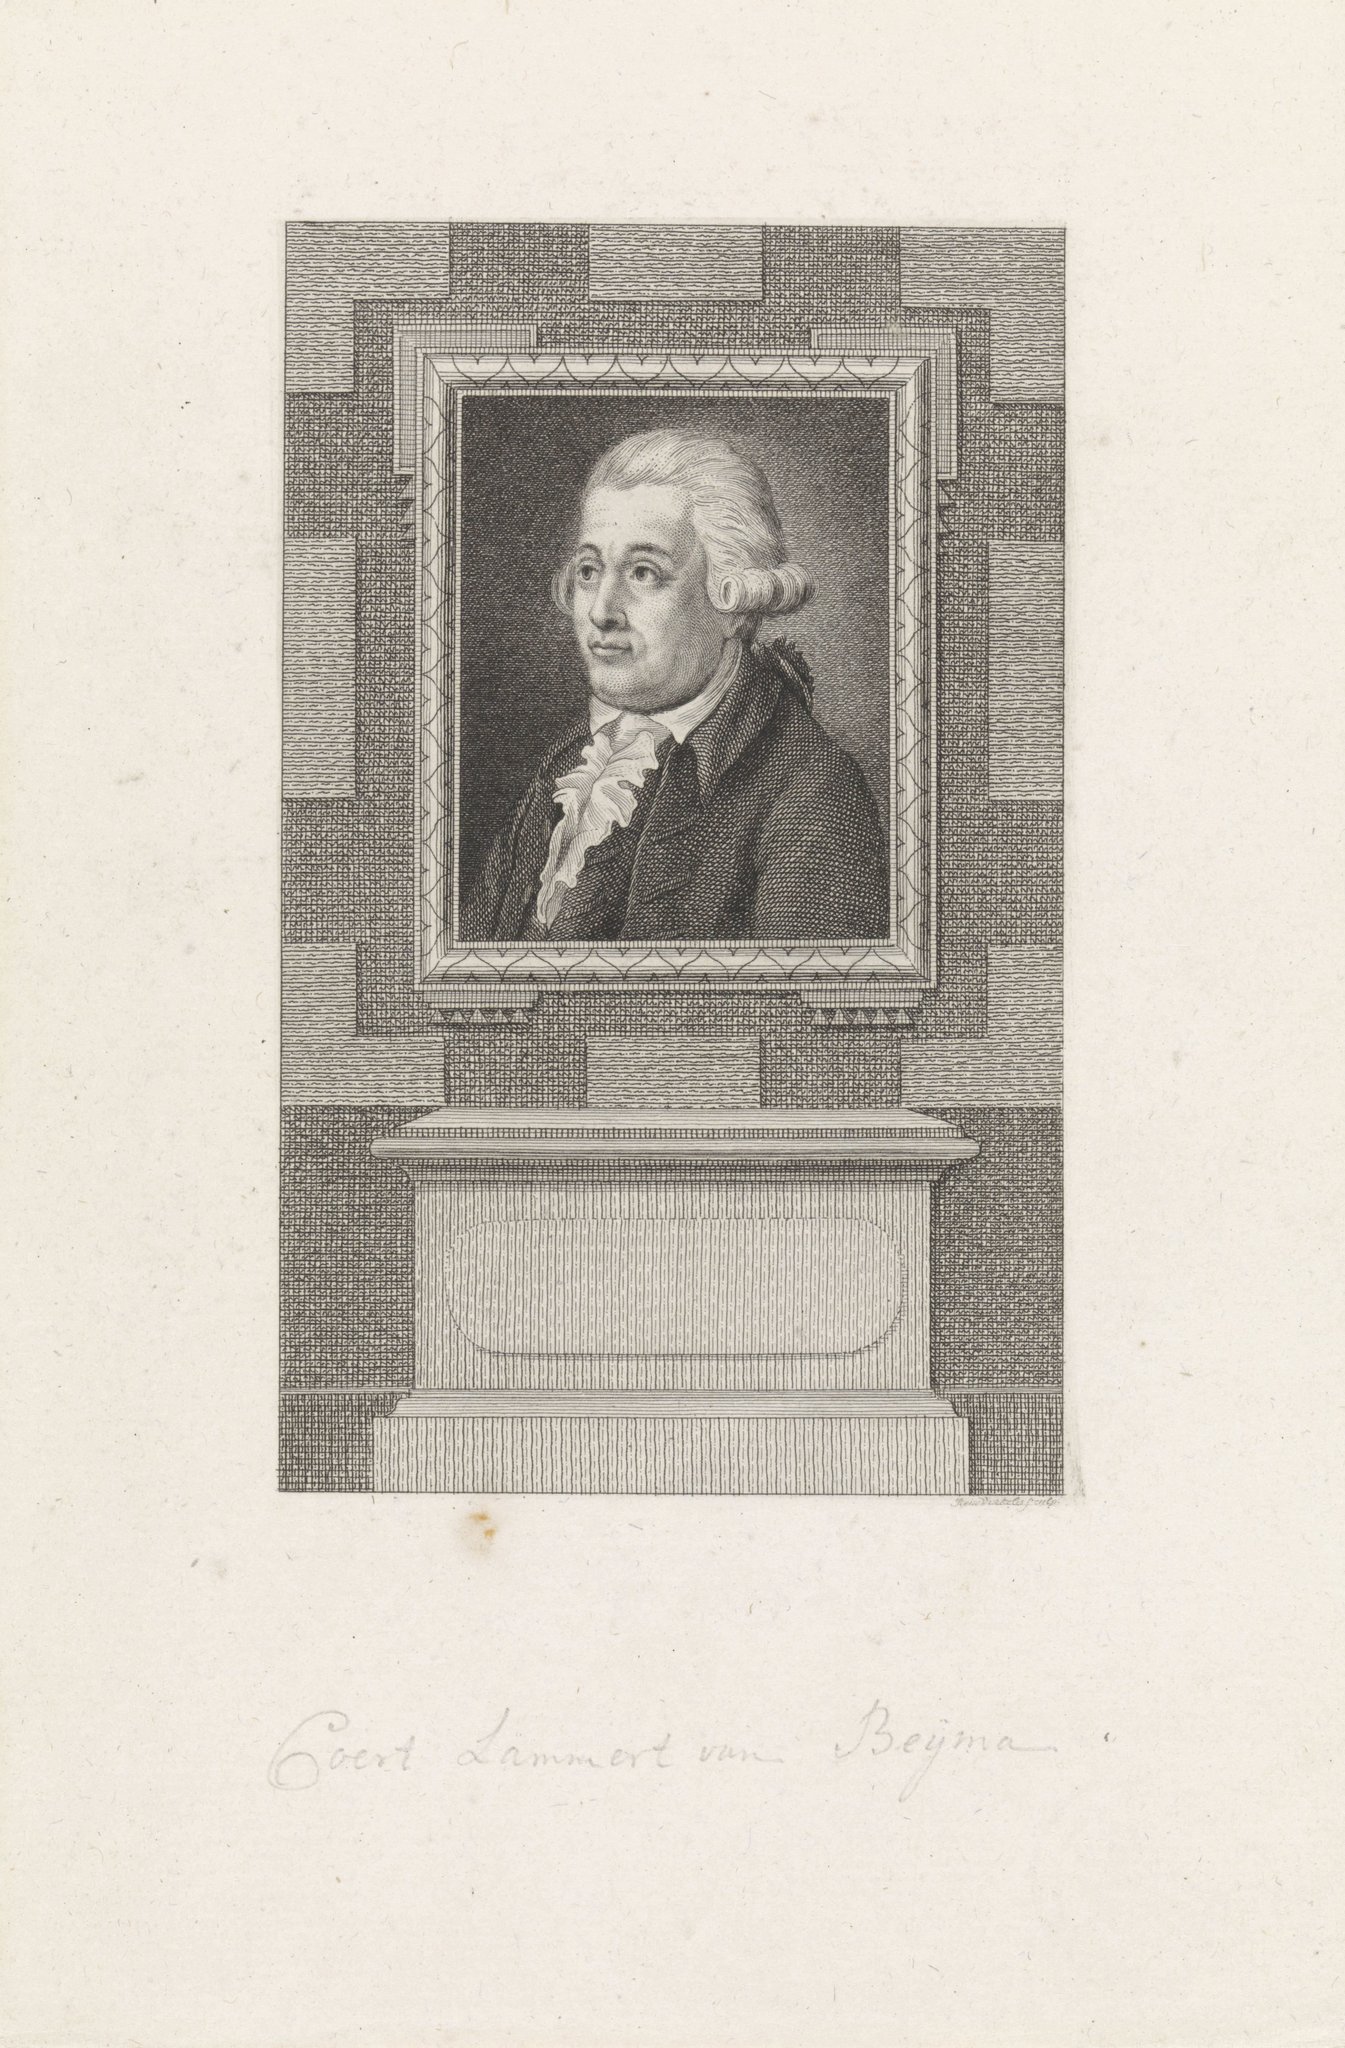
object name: print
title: Portret van Coert Lambertus van Beyma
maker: reinier vinkeles (i)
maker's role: draughtsman, print maker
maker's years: 1741-1816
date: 1794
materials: paper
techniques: engraving, etching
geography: amsterdam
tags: harlingen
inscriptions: collector's mark: Lugt 240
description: Latere staat prent gebruikt als boekillustratie in: Wagenaar, Jan. Vaderlandsche historie, (...) ten vervolge van Wagenaars Vaderlandsche historie. Dl. 1-43. Amsterdam: Johannes Allart, 1786-1809. Dertiende deel, 1794.